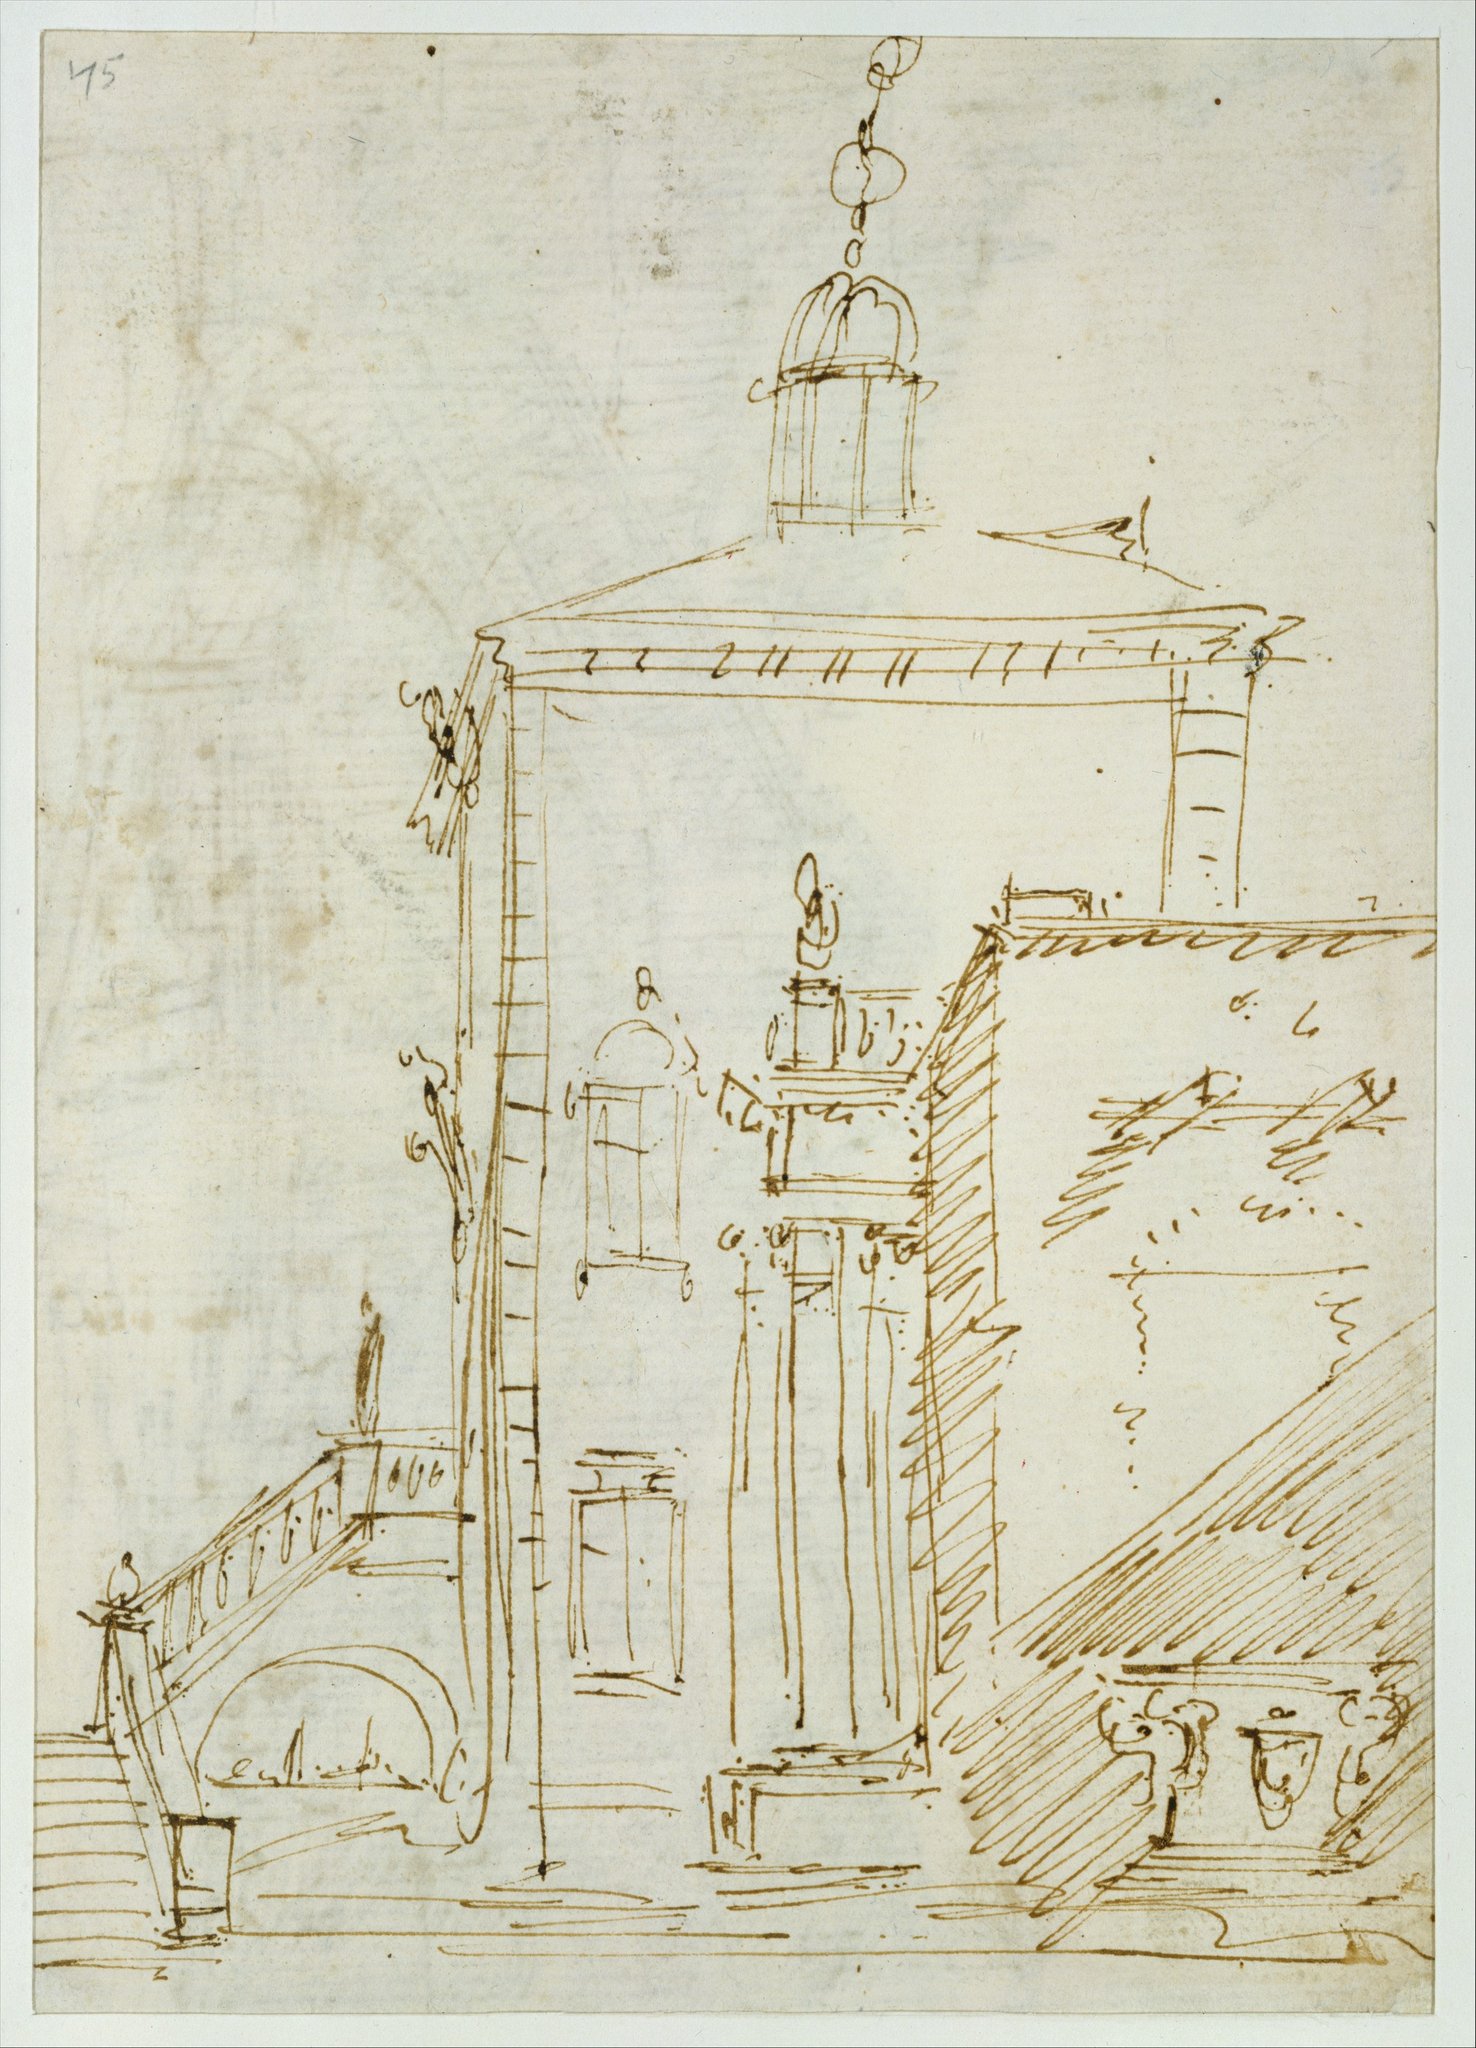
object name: drawing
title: A Magnificent Pavilion by the Lagoon (recto); The Grand Canal, with the Rialto Bridge from the South (verso)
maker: canaletto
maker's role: artist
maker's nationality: italian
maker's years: 1697-1768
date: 1727-1729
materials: graphite, ink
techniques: pen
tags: buildings,venice